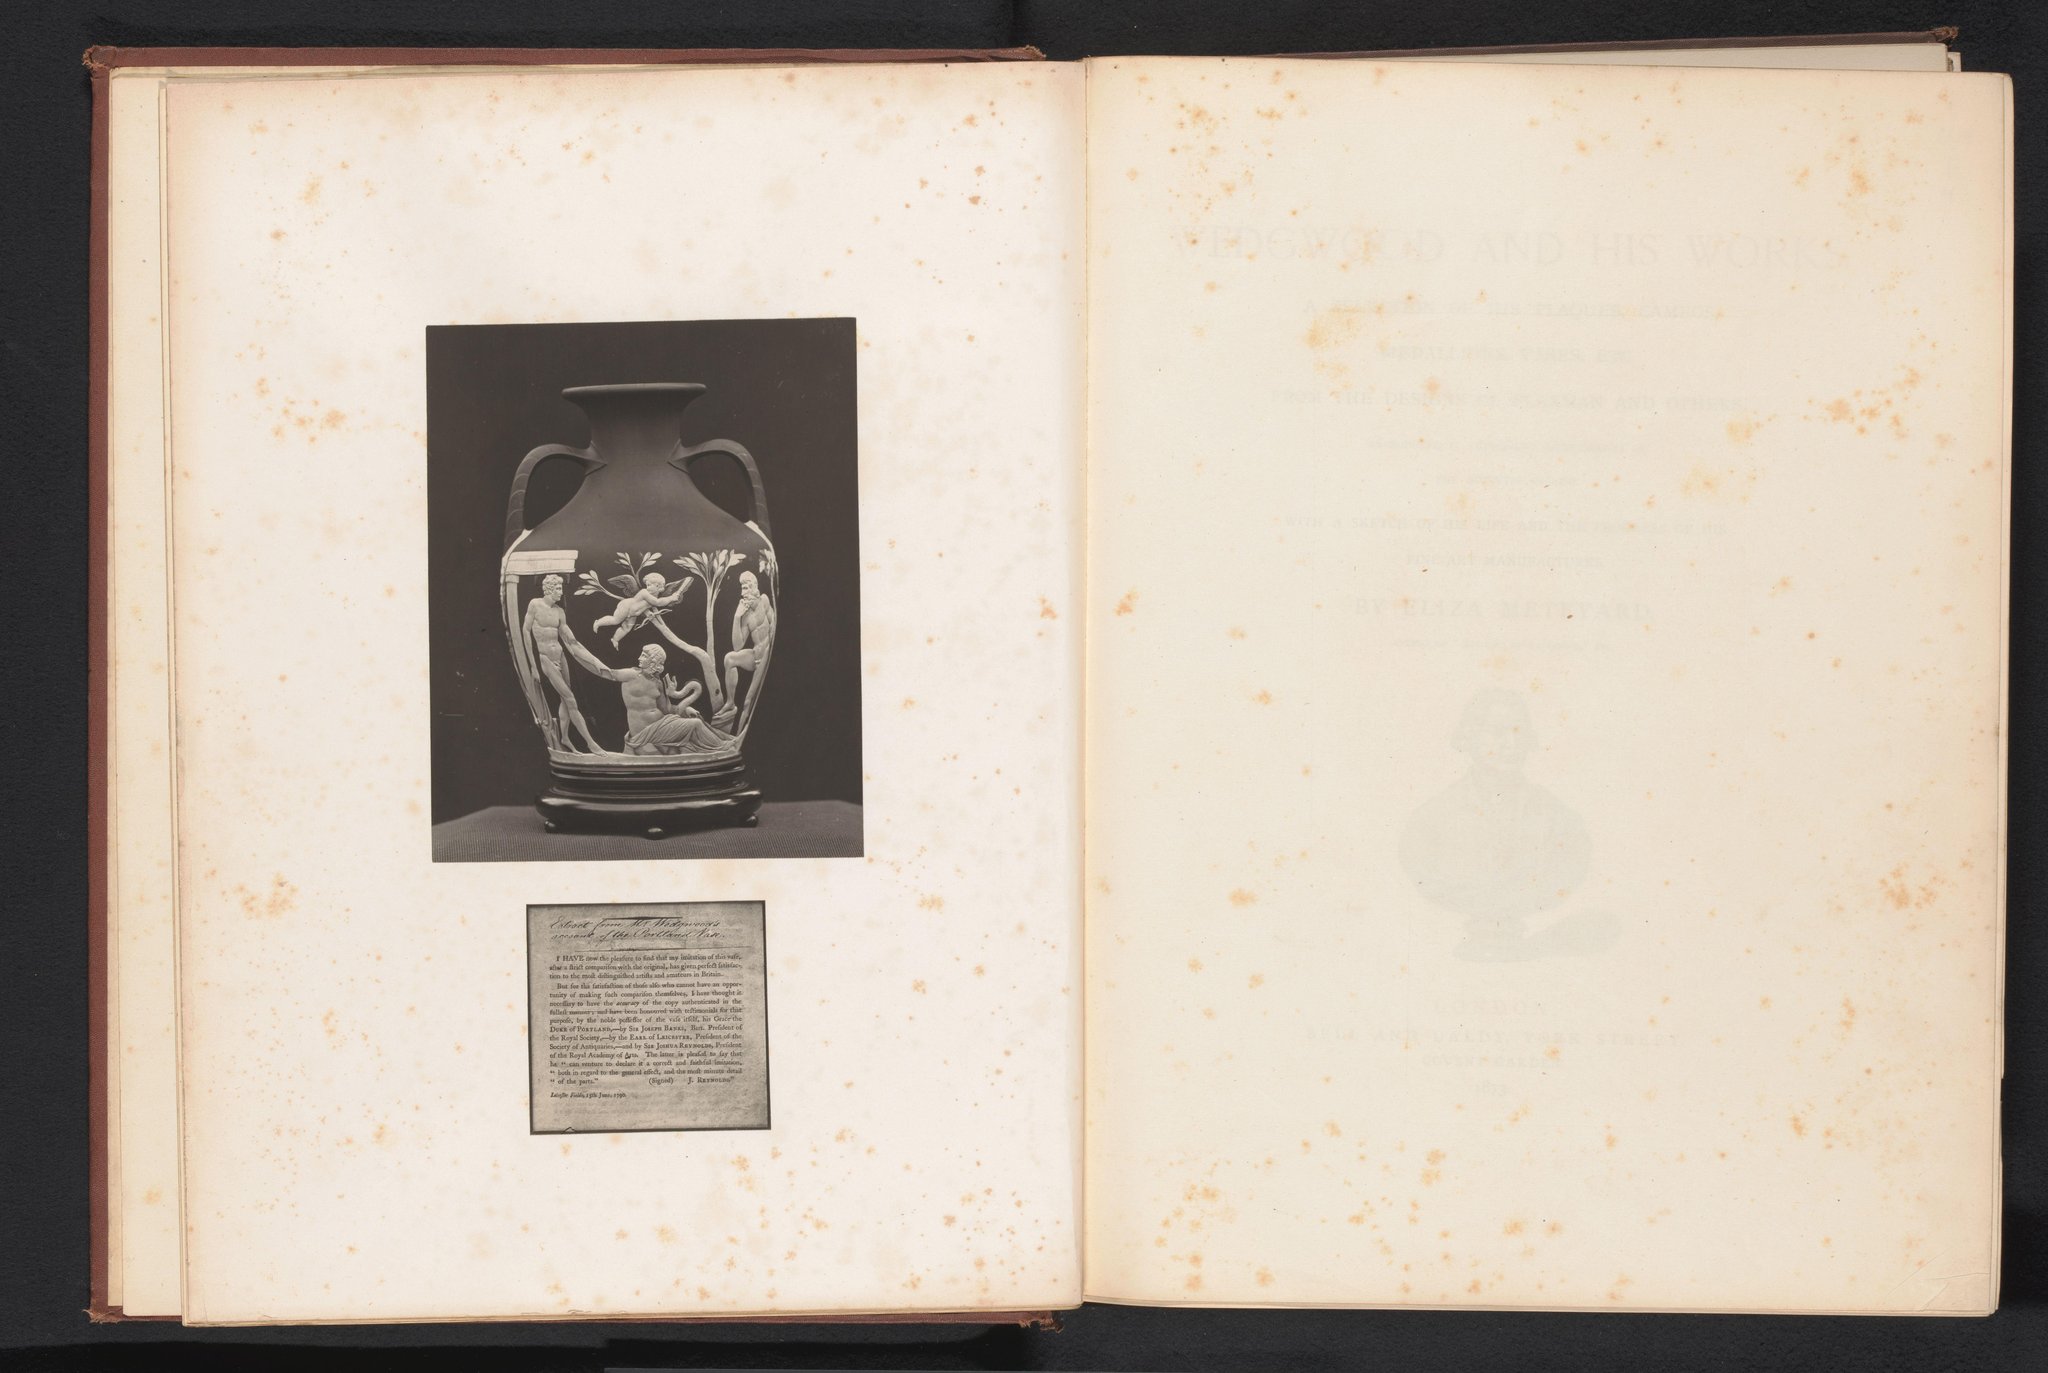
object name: photograph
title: Brief en de Wedgwood replica van de Portlandvaas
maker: joseph cundall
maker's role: fotograaf, schrijver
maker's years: 1818-1895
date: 1868-1873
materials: paper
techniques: carbon print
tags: container of ceramics: jar, jug, pot, vase, letter, envelope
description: Foto op tweede ongenummerde pagina na pagina viii.